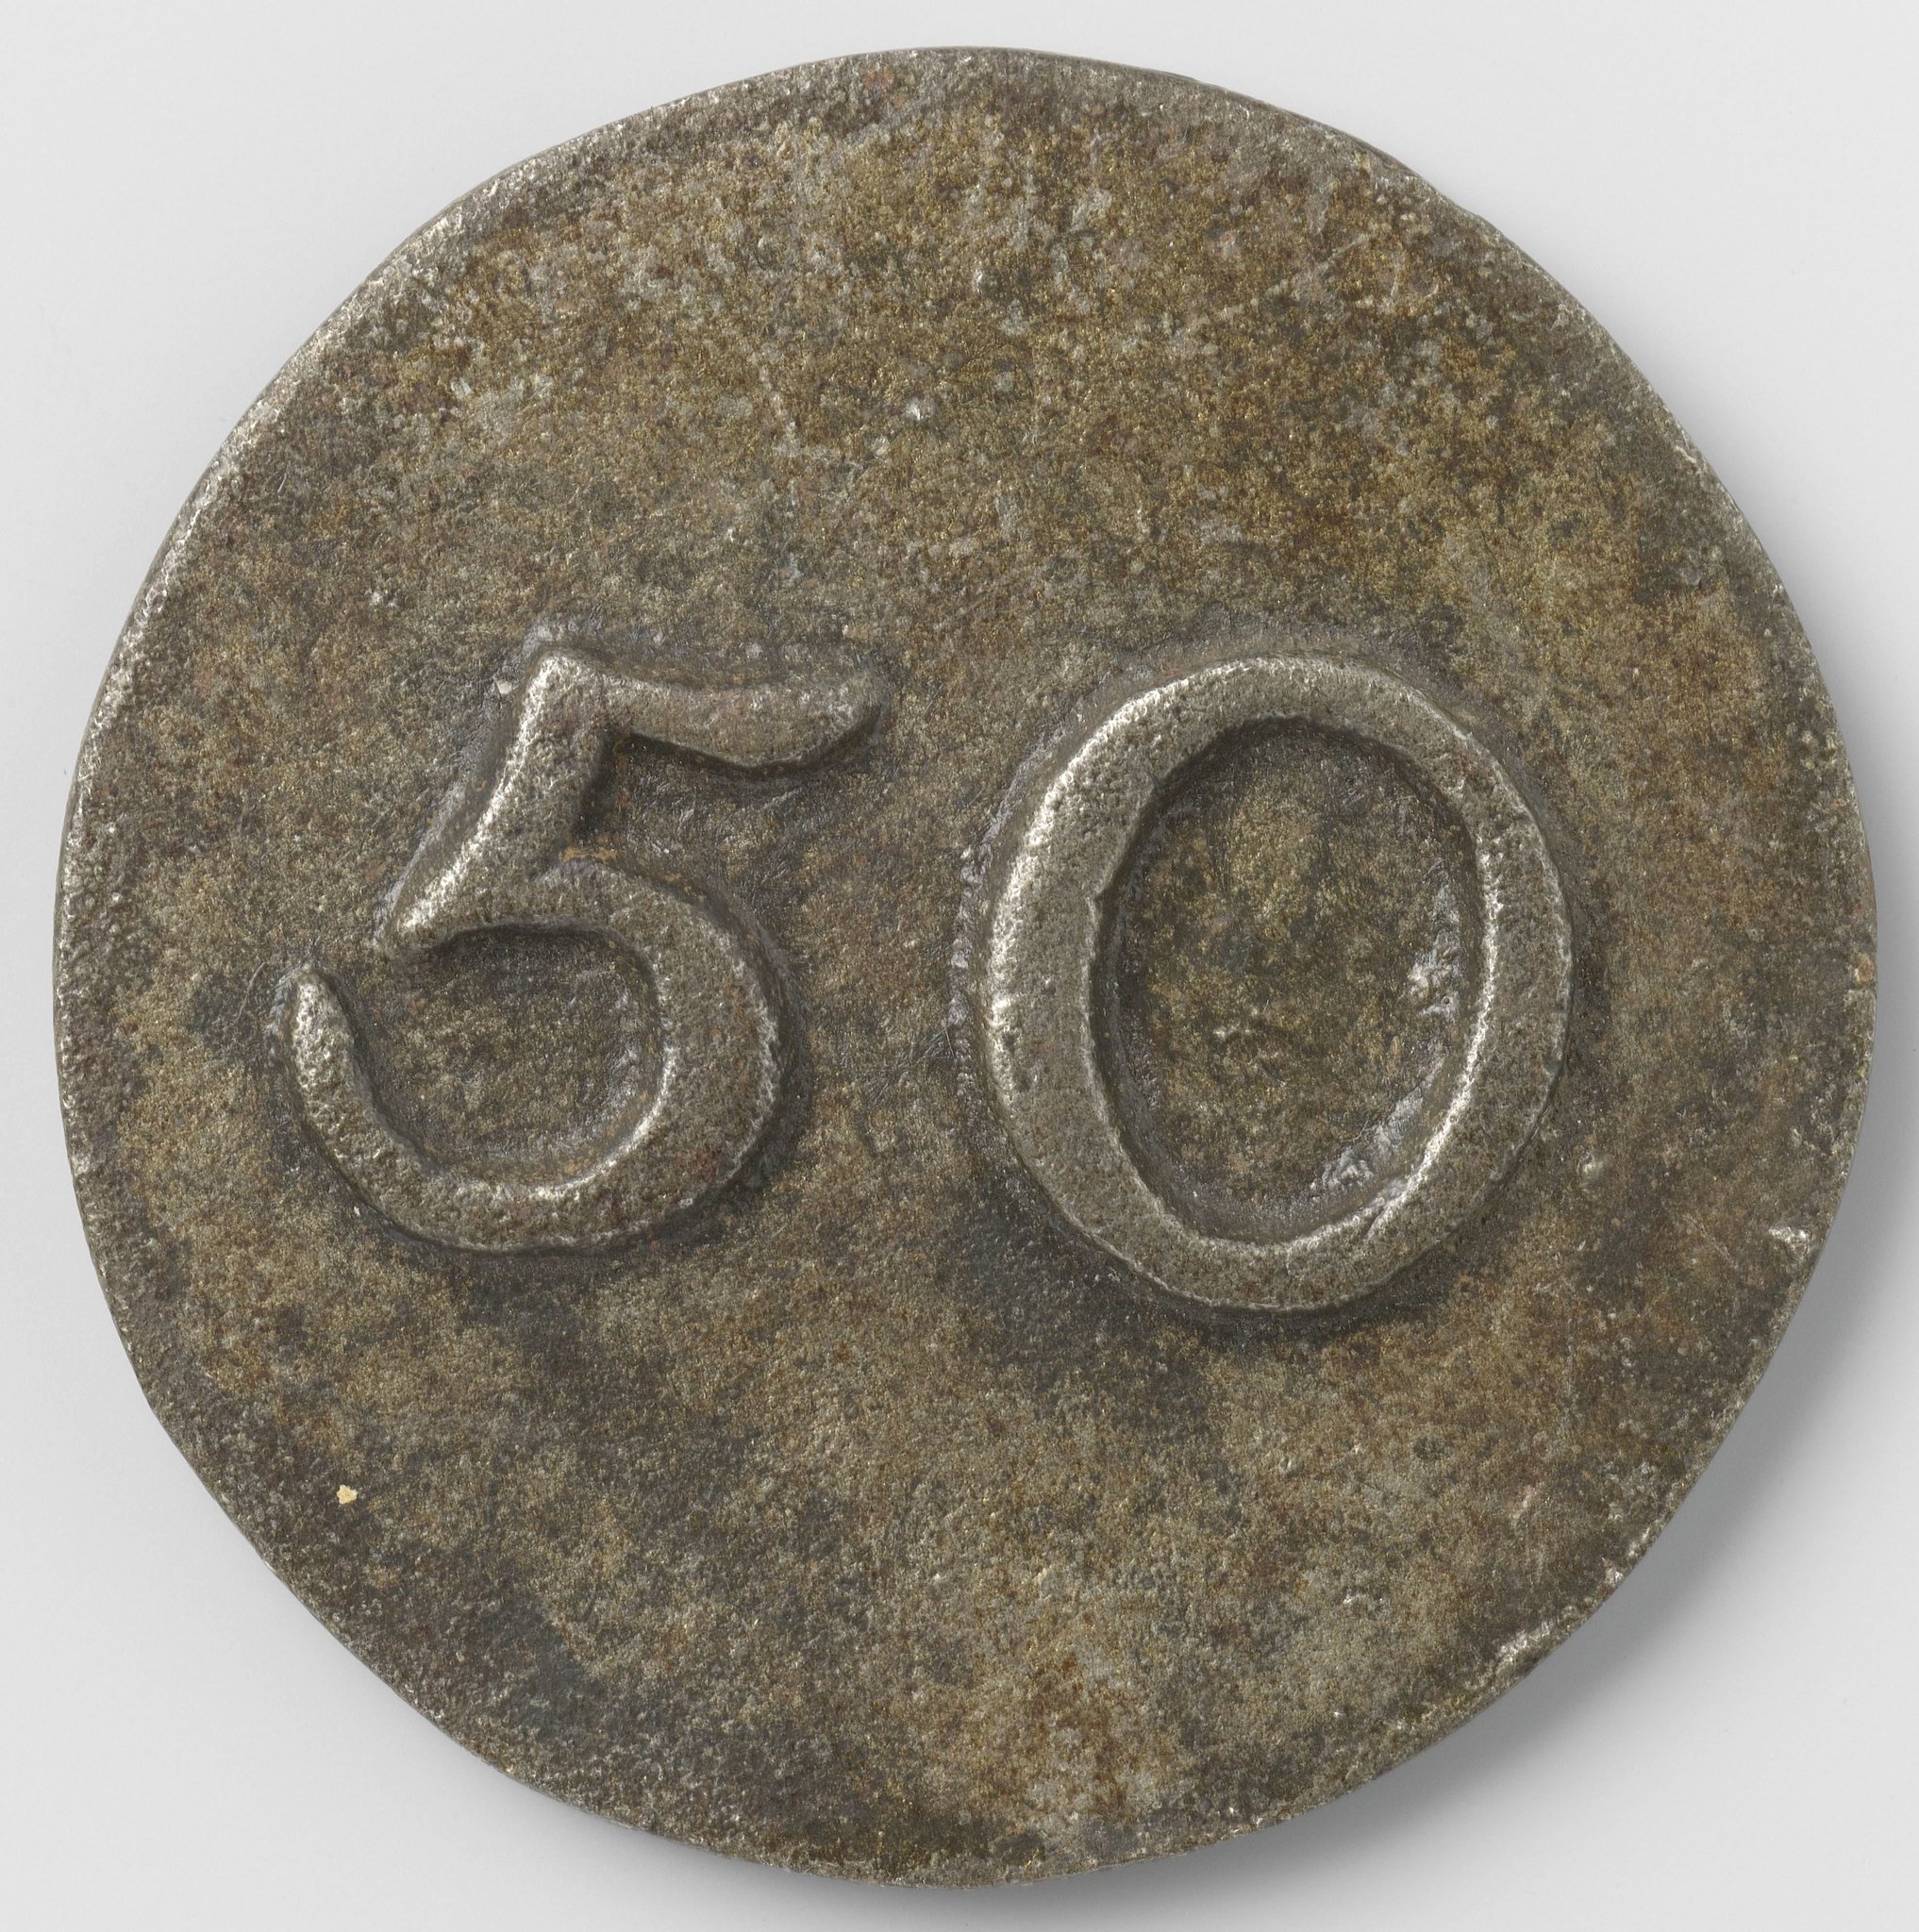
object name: huismunt prison money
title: Strafgevangenis Ommerschans, huismunt geslagen op last van de Maatschappij van Weldadigheid ter waarde van 50 cent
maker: Anonymous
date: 1818-1859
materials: iron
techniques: casting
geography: netherlands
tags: maatschappij van weldadigheid, ommerschans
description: Voorzijde: letters O en S. Keerzijde: cijfer 50